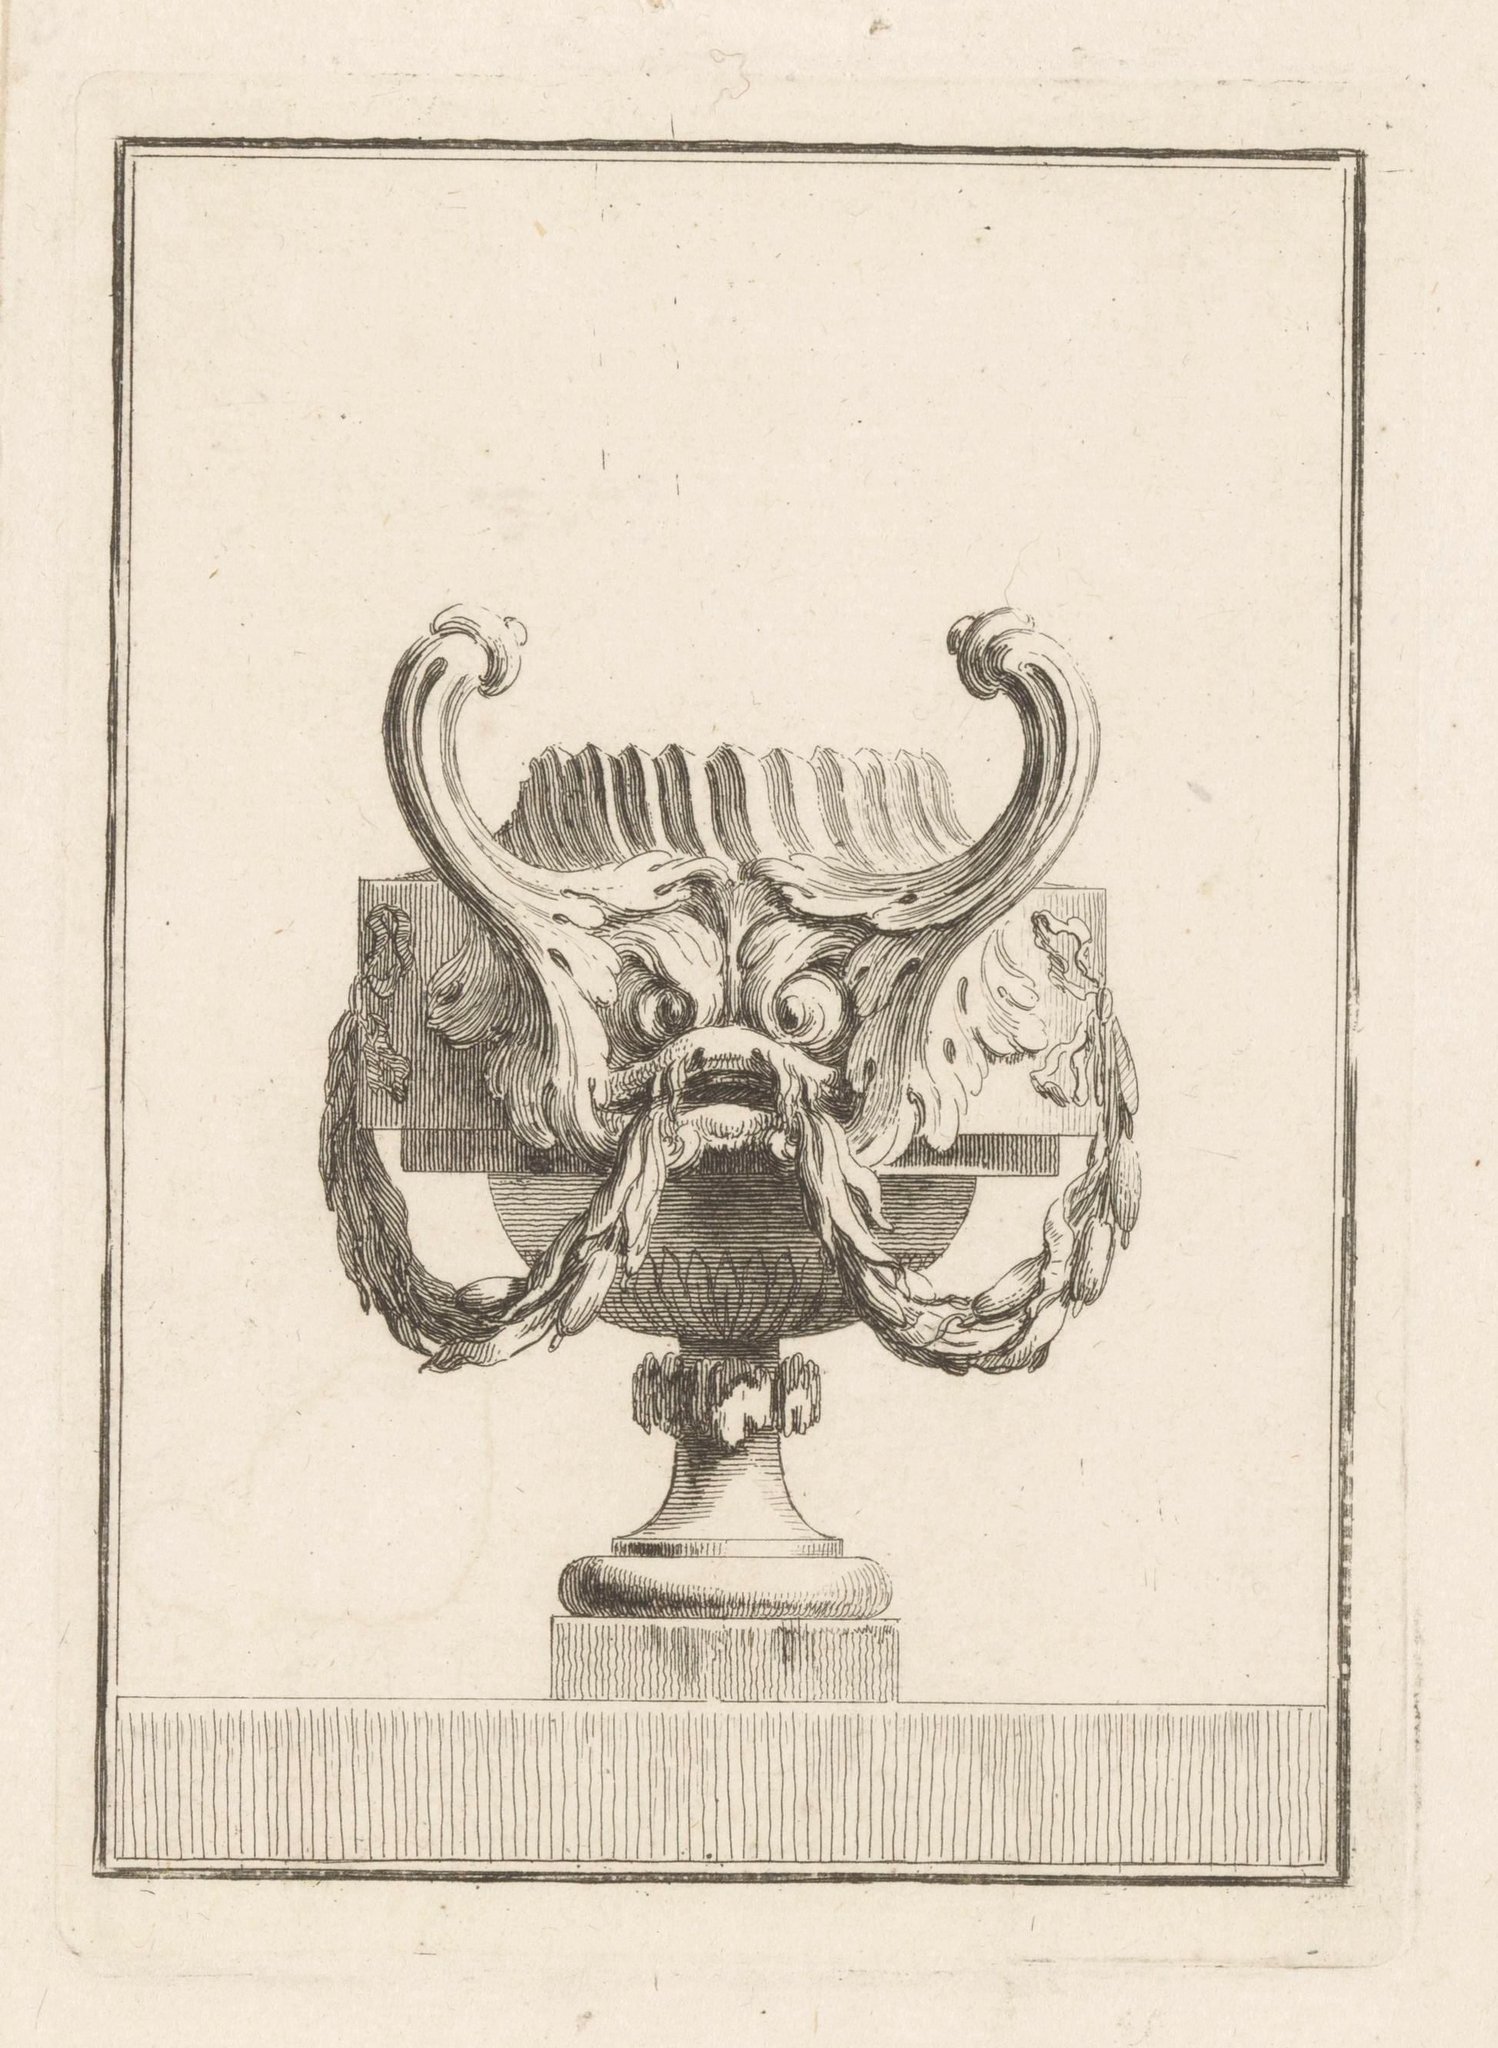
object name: print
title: Nouveau livre de Vases (...)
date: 1755-1782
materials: paper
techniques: etching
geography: paris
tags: fabulous animals (sometimes wrongly called 'grotesques'); 'mostri' (ripa), vase ~ ornament, ornament ~ festoon, garland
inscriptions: collector's mark: Lugt 2228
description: Een vaas met kop van een fantasiewezen met hoorns en guirlandes.